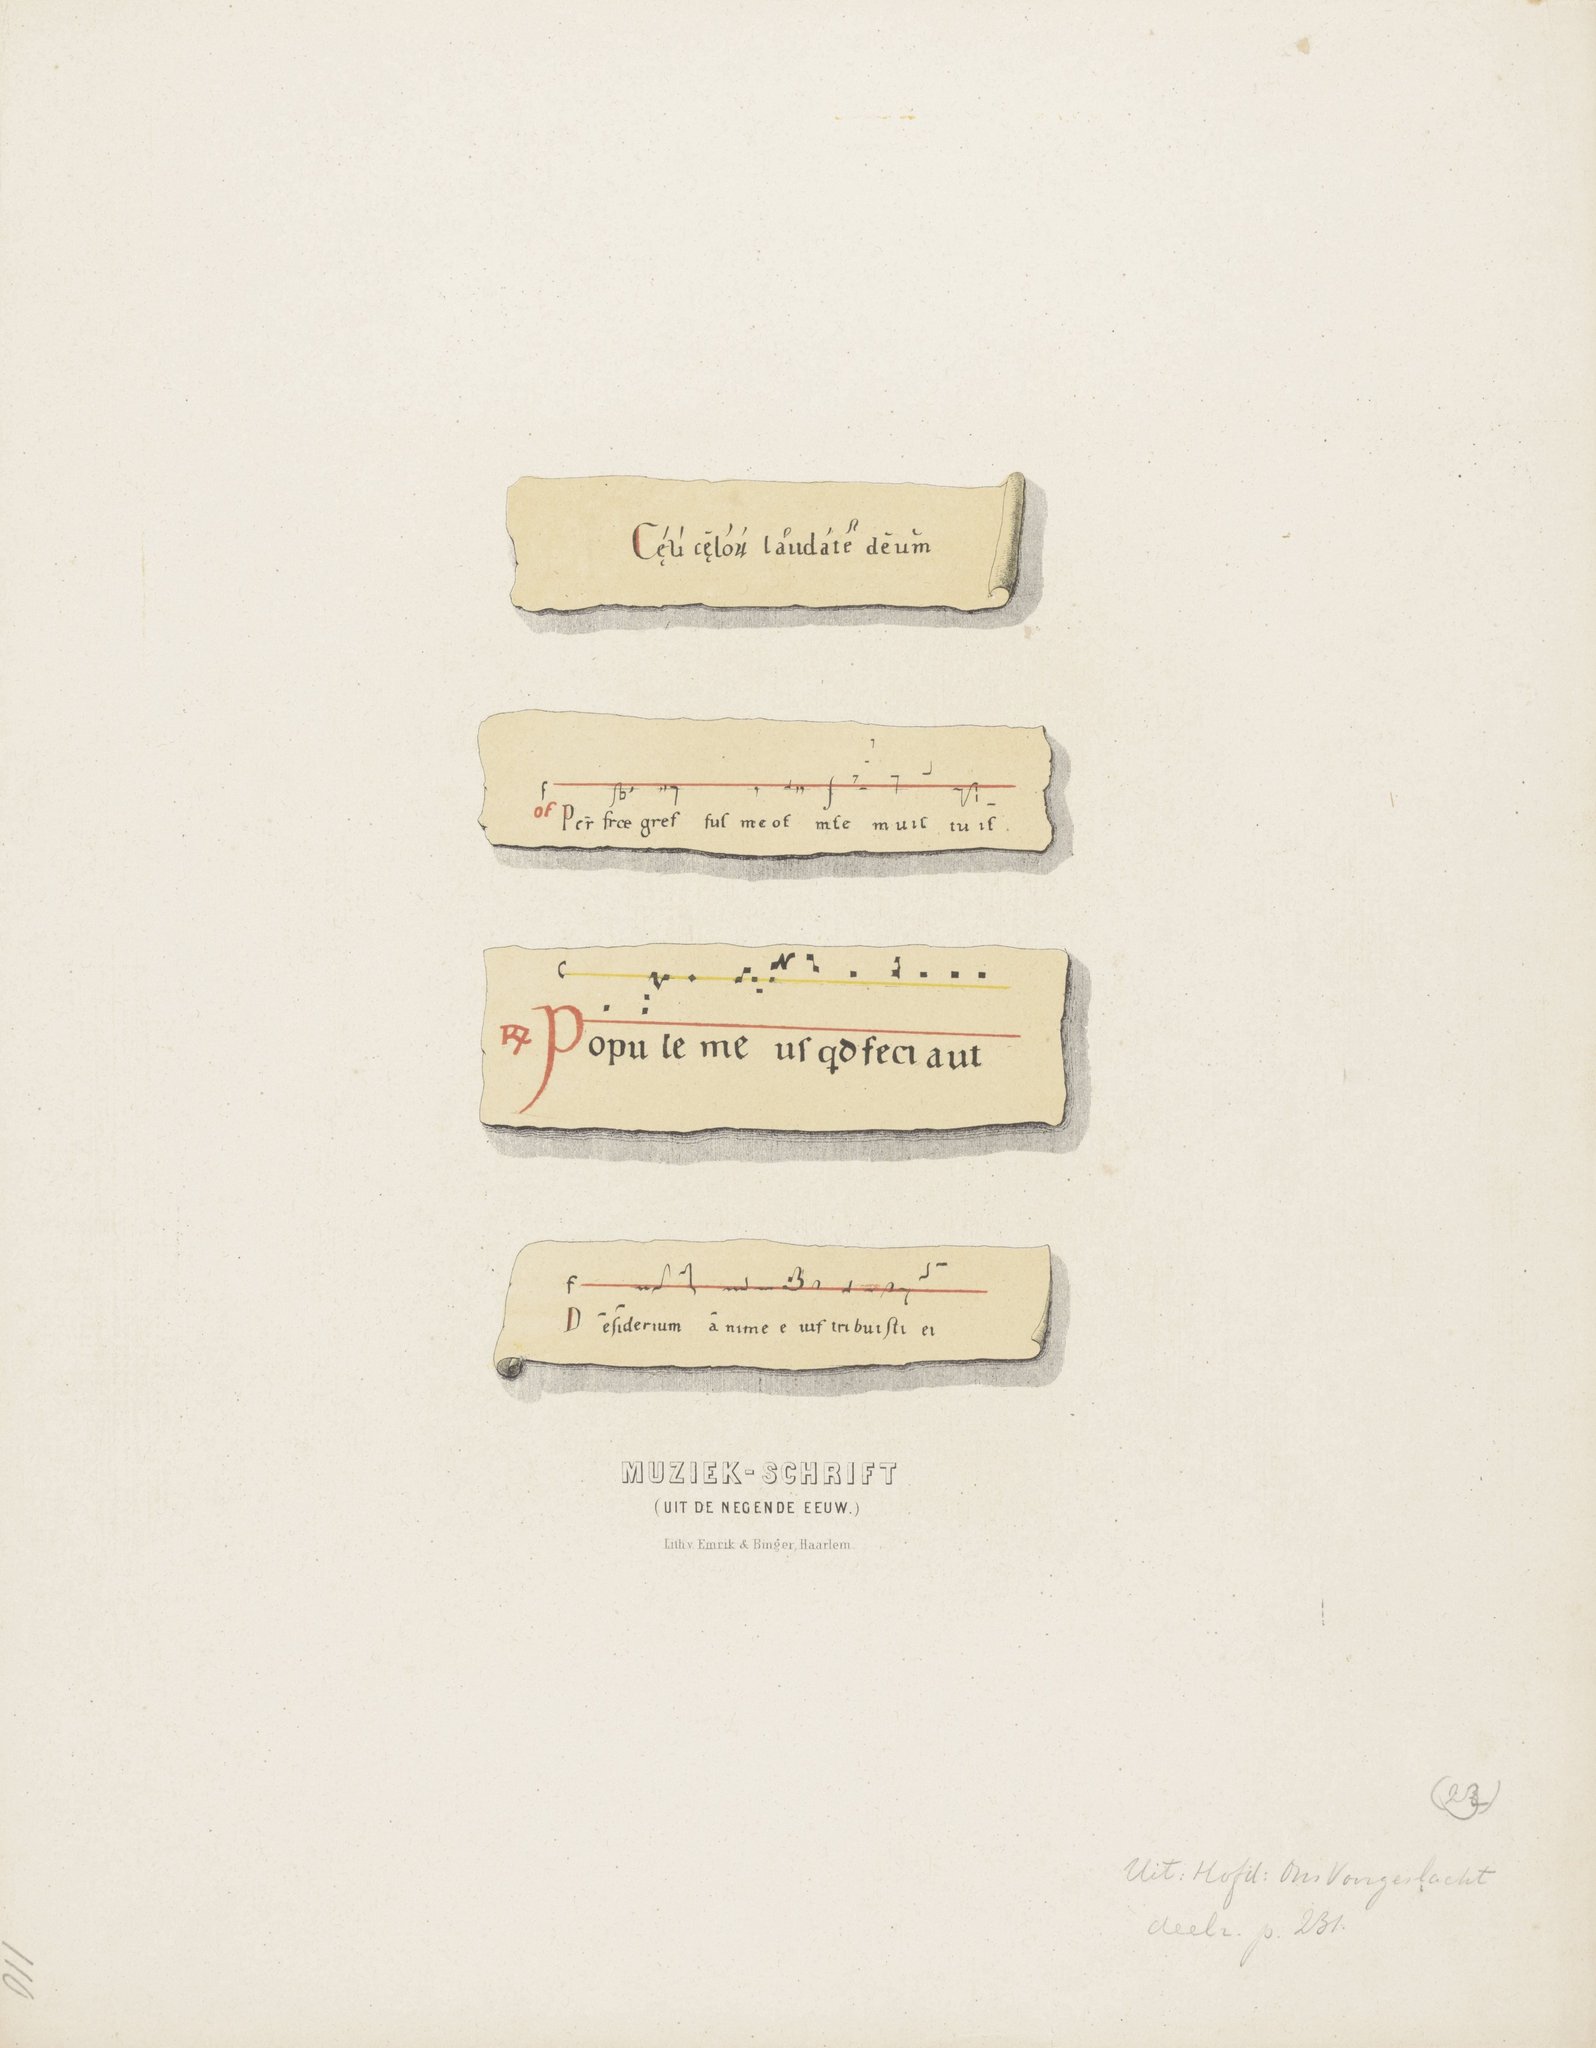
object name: print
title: Muziek-schrift (uit de negende eeuw)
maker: Anonymous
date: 1857-1864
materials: paper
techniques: tone lithography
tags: manuscript of musical score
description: Illustratie voor: W.J. Hofdijk, Ons voorgeslacht in zijn dagelyksch leven geschilderd, Kruseman, Haarlem 1859-1864, dl. 2, p. 231.